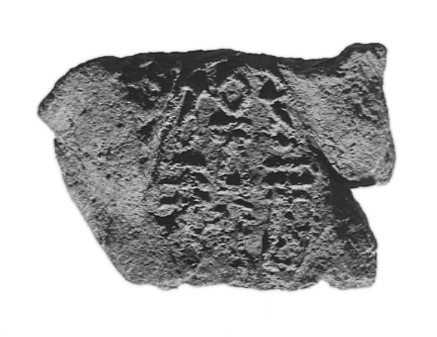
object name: sealing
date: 2030-1640 BCE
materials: clay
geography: egypt